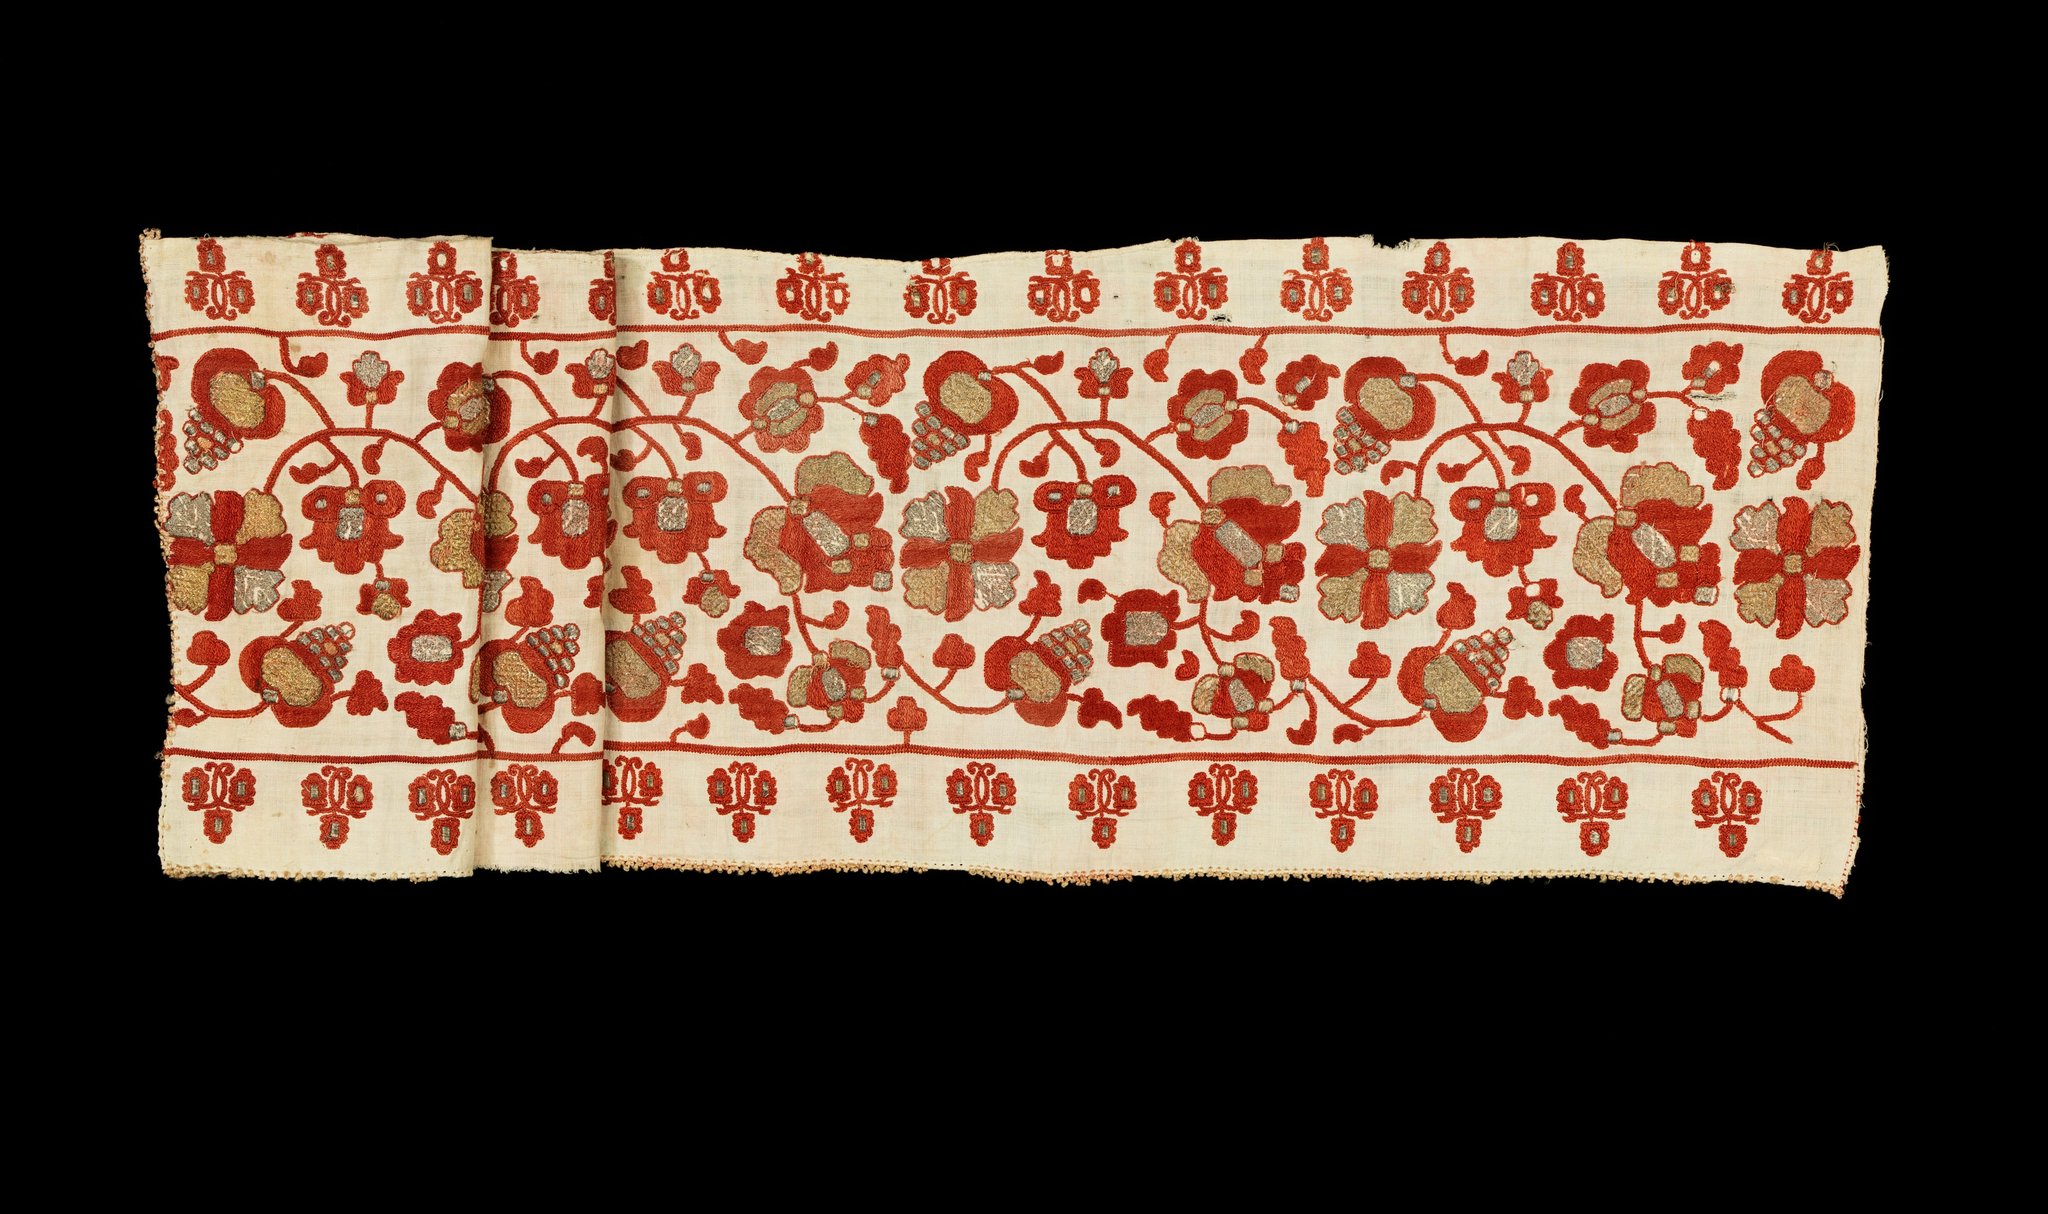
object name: textile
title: Fragment of a shirt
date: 1776-1800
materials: linen, metal, silk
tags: flowers